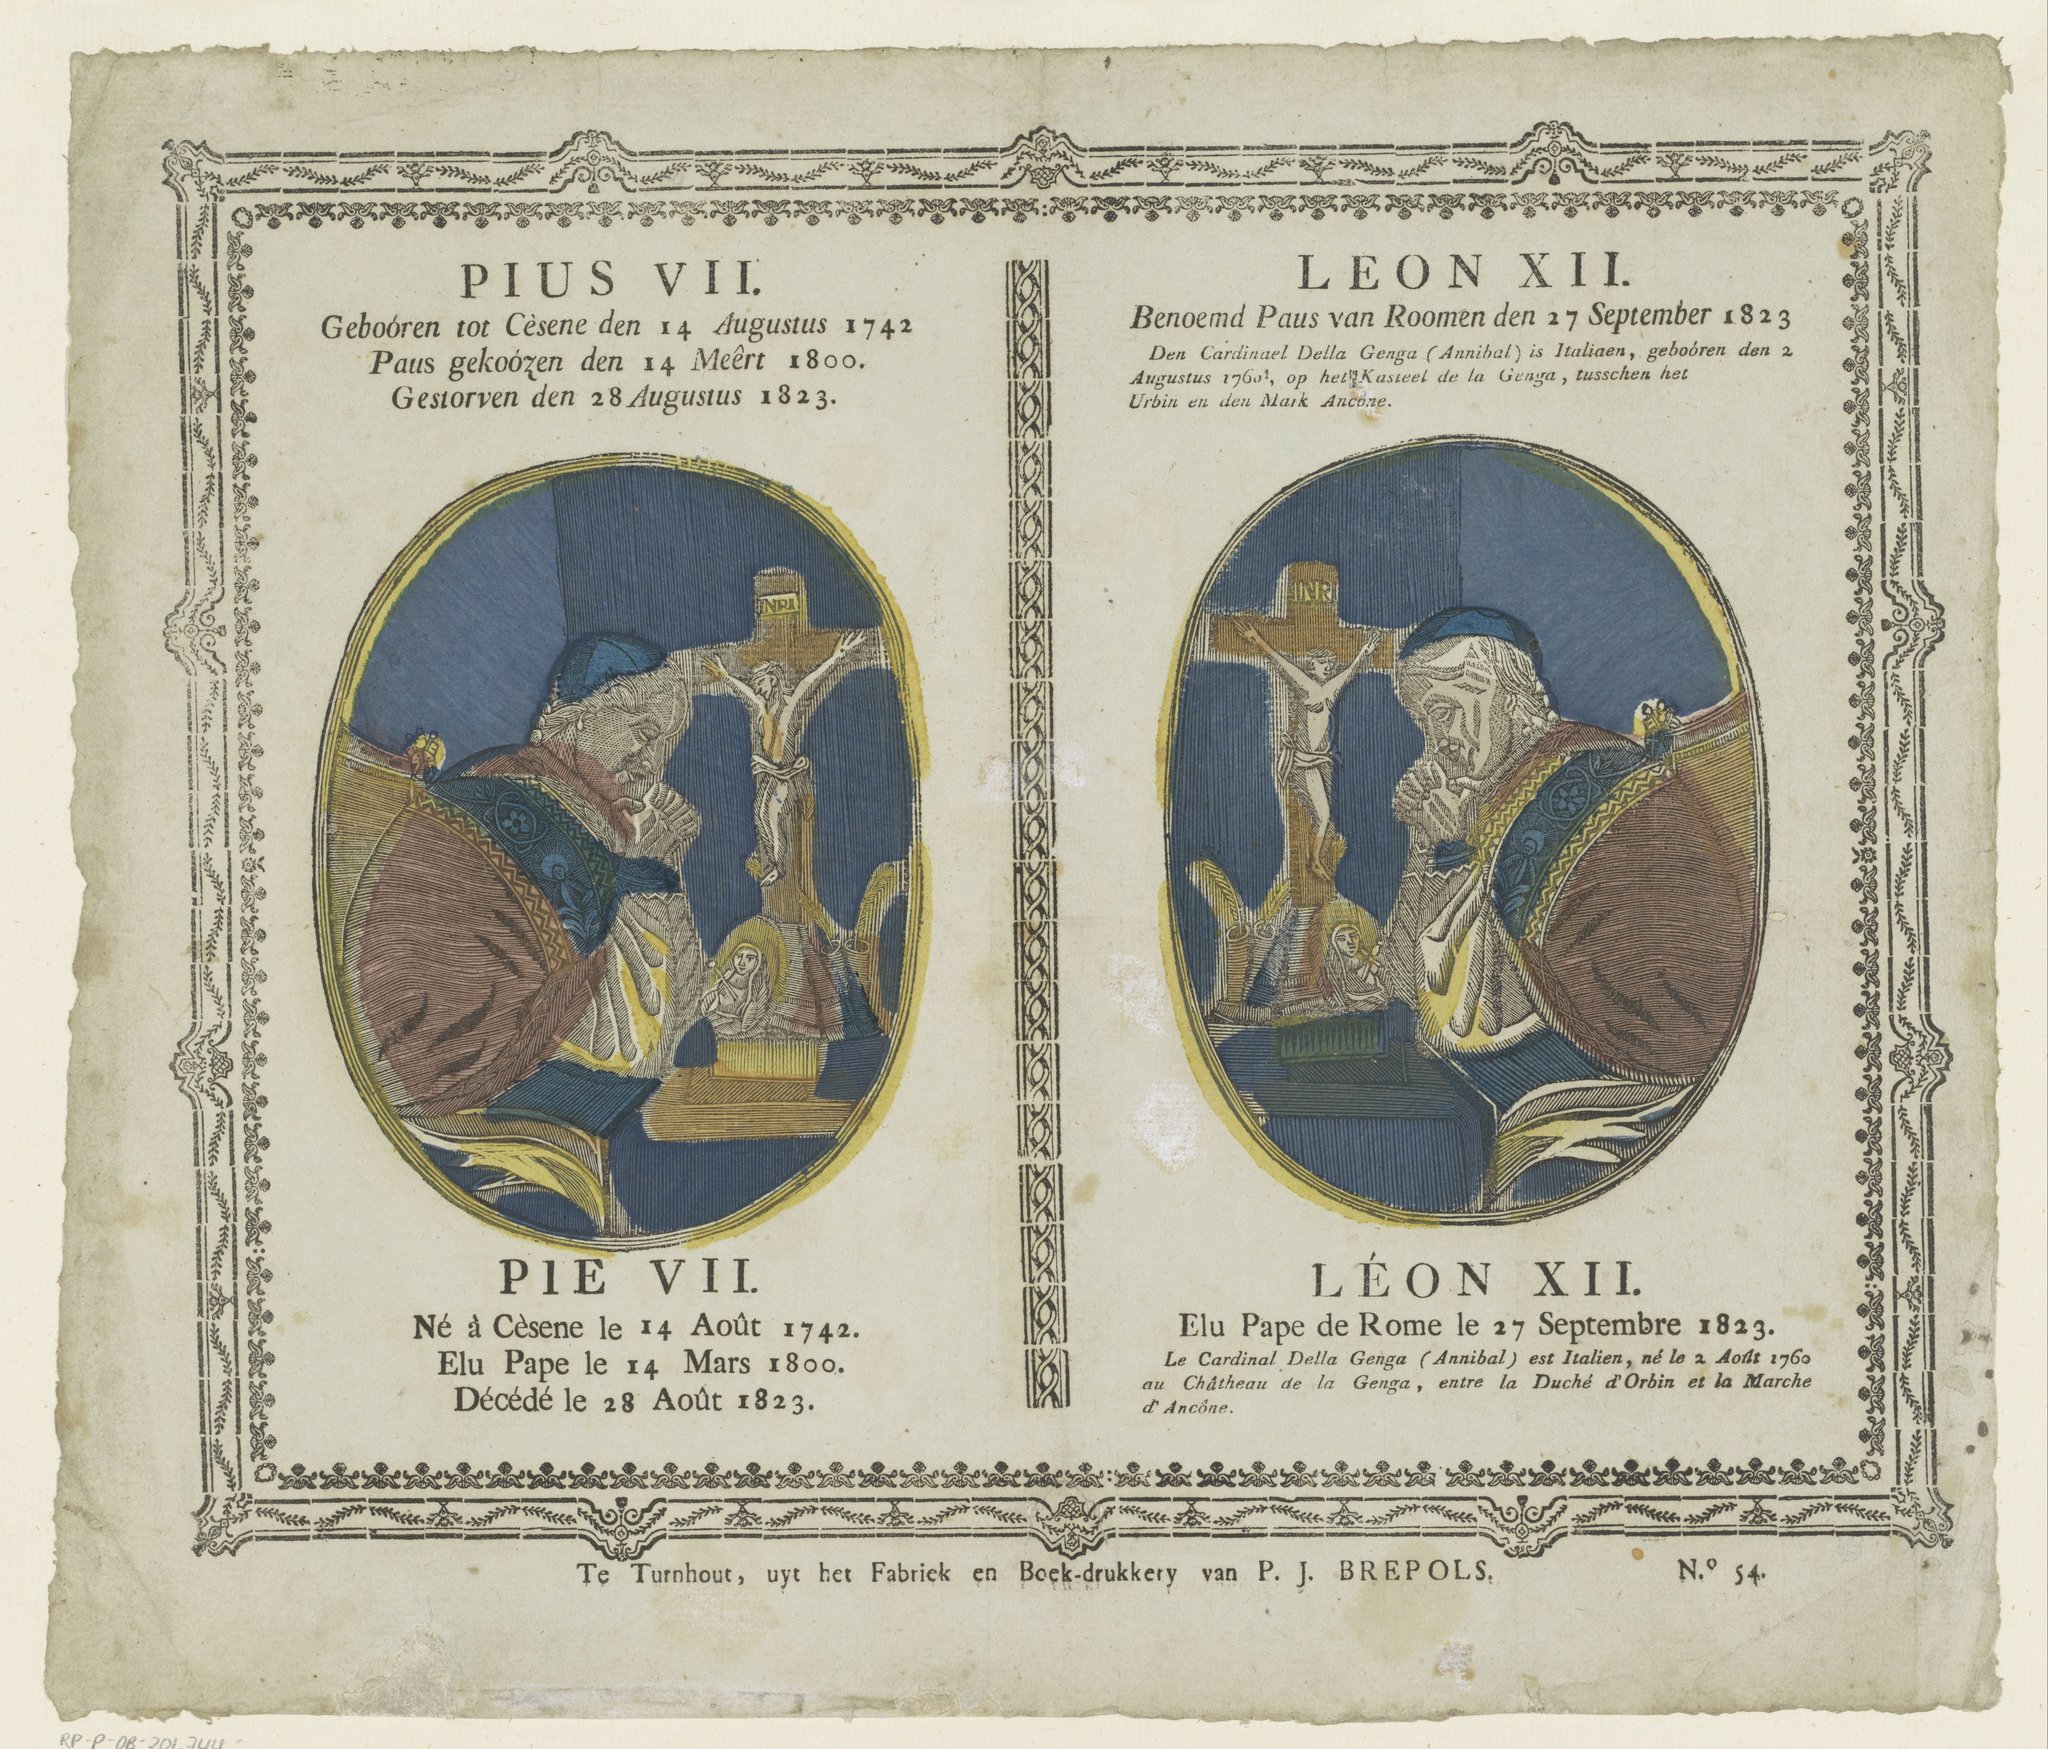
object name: popular print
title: Pius VII / Pie VII / Leon XII / Léon XII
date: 1800-1833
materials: paper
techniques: colour, letterpress printing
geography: turnhout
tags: pius vii, rome, pope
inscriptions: collector's mark: Lugt 2760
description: Twee ovale voorstellingen. Links de biddende paus Pius VII aan een tafel met crucifix, rechts de biddende paus Leo XII aan een tafel met crucifix. Boven en onder de voorstellingen tekst in boekdruk in het Nederlands en in het Frans. Geheel omgeven door een sierrand. Genummerd rechtsonder: No. 54.